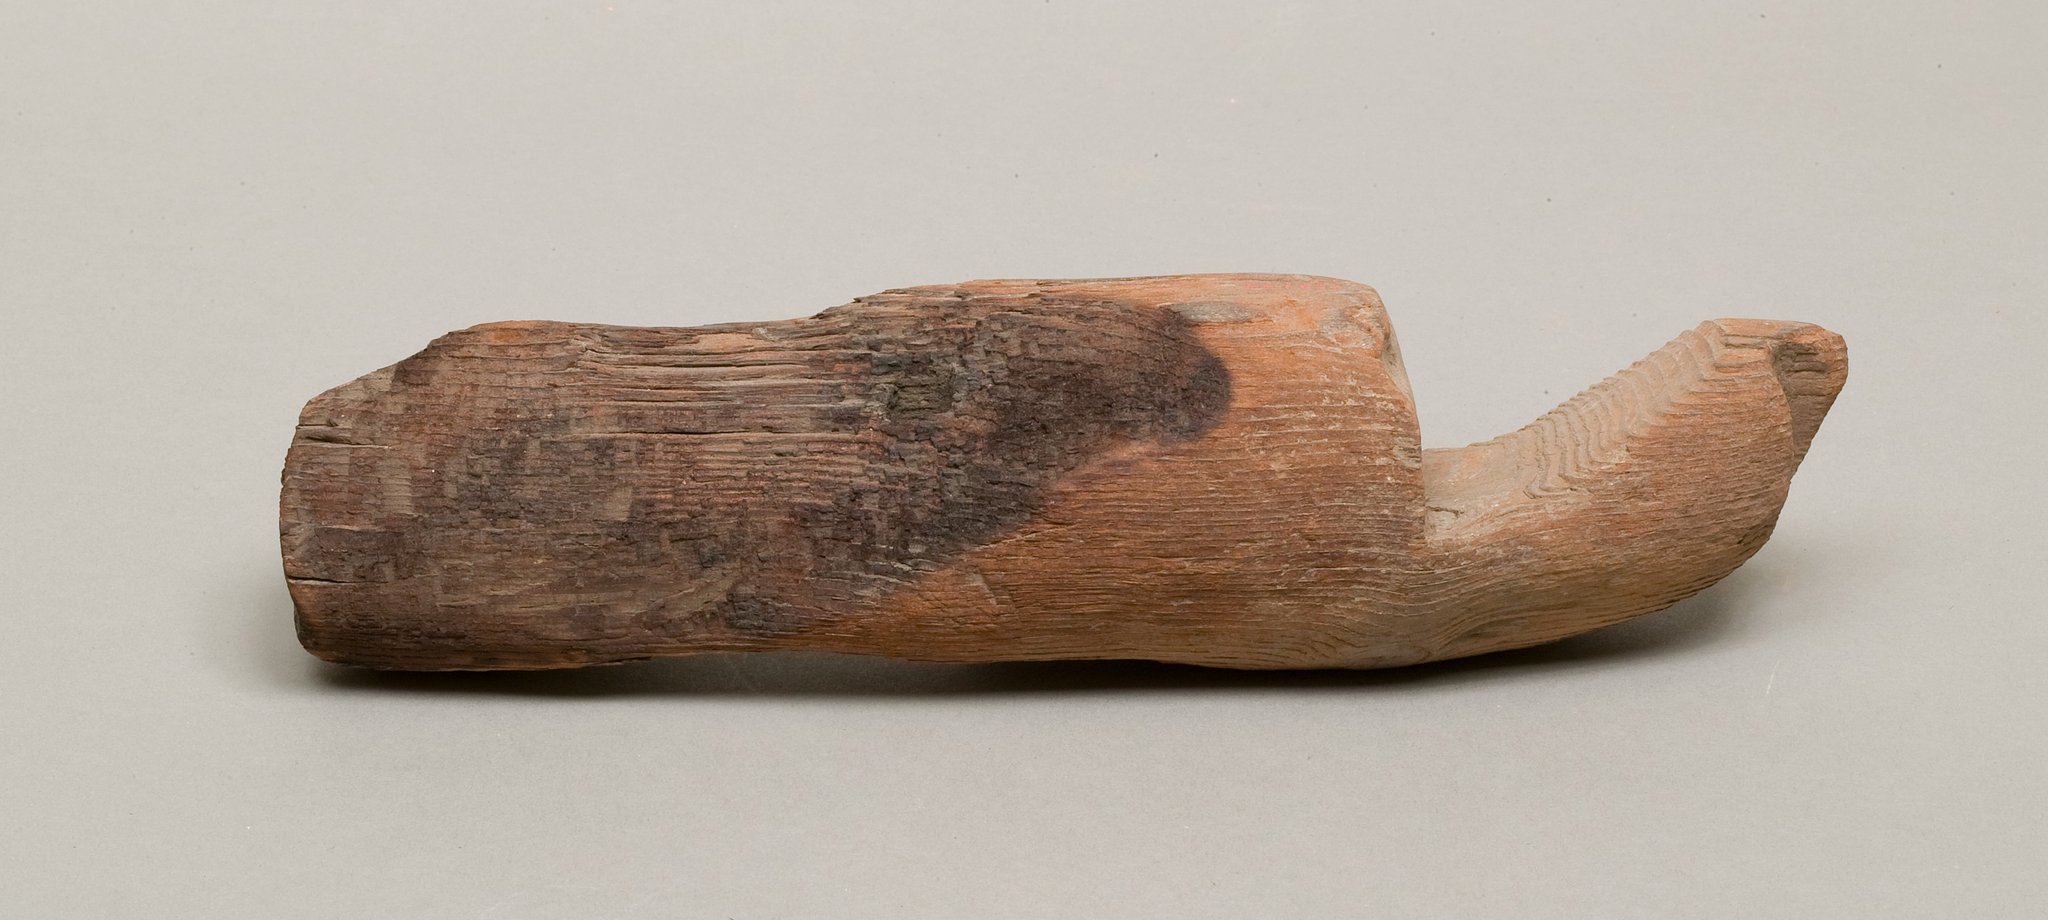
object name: heddle jack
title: Loom equipment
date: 1850-1070 BCE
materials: wood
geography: egypt